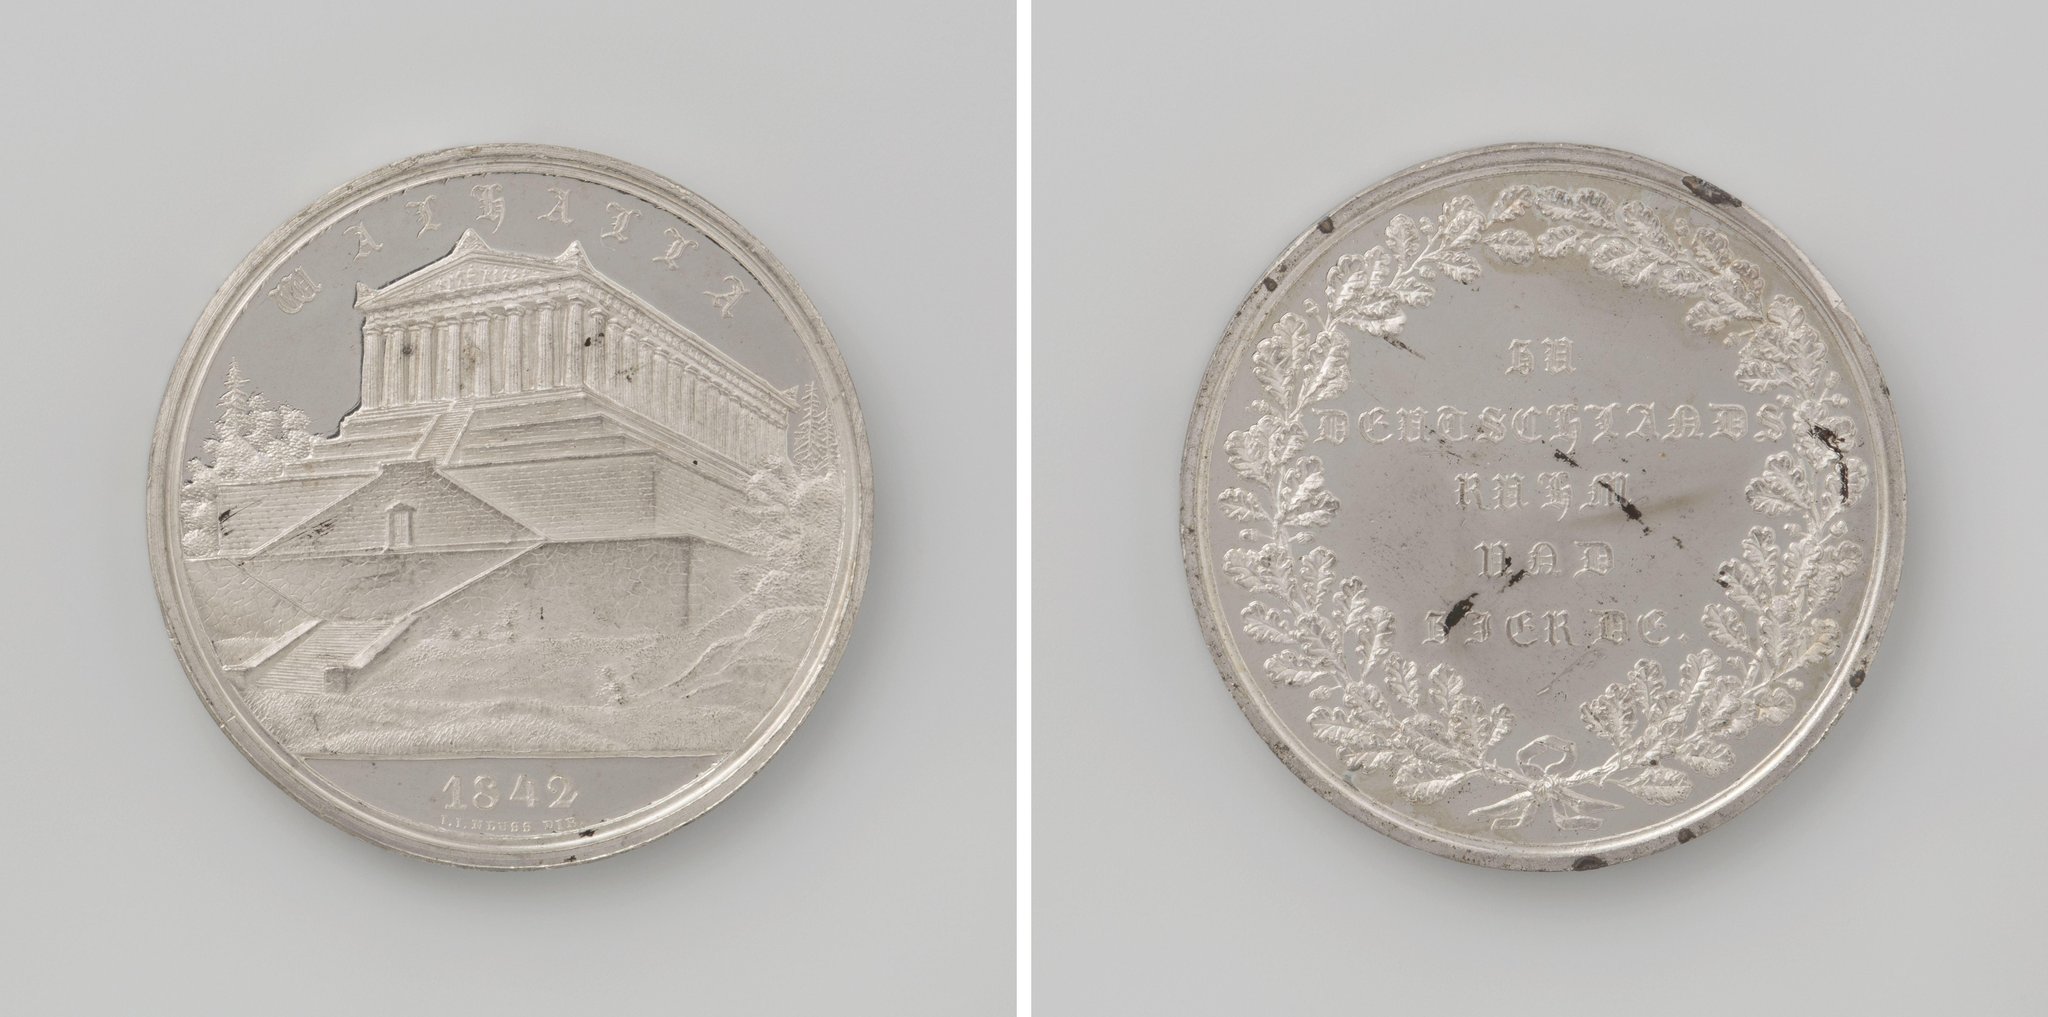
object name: history medal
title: Oprichting van het Walhalla, "Tempel deutscher Ehren" bij Regensburg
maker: johann jakob neuss (der jüngere)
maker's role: medailleur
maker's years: 1770-1847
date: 1842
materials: composition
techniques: striking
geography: augsburg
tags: donaustauf, walhalla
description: Voorzijde: Griekse tempel op hoog bastion binnen omschrift in Gothische letters. Keerzijde: opschrift in Gothische letters binnen eikekrans